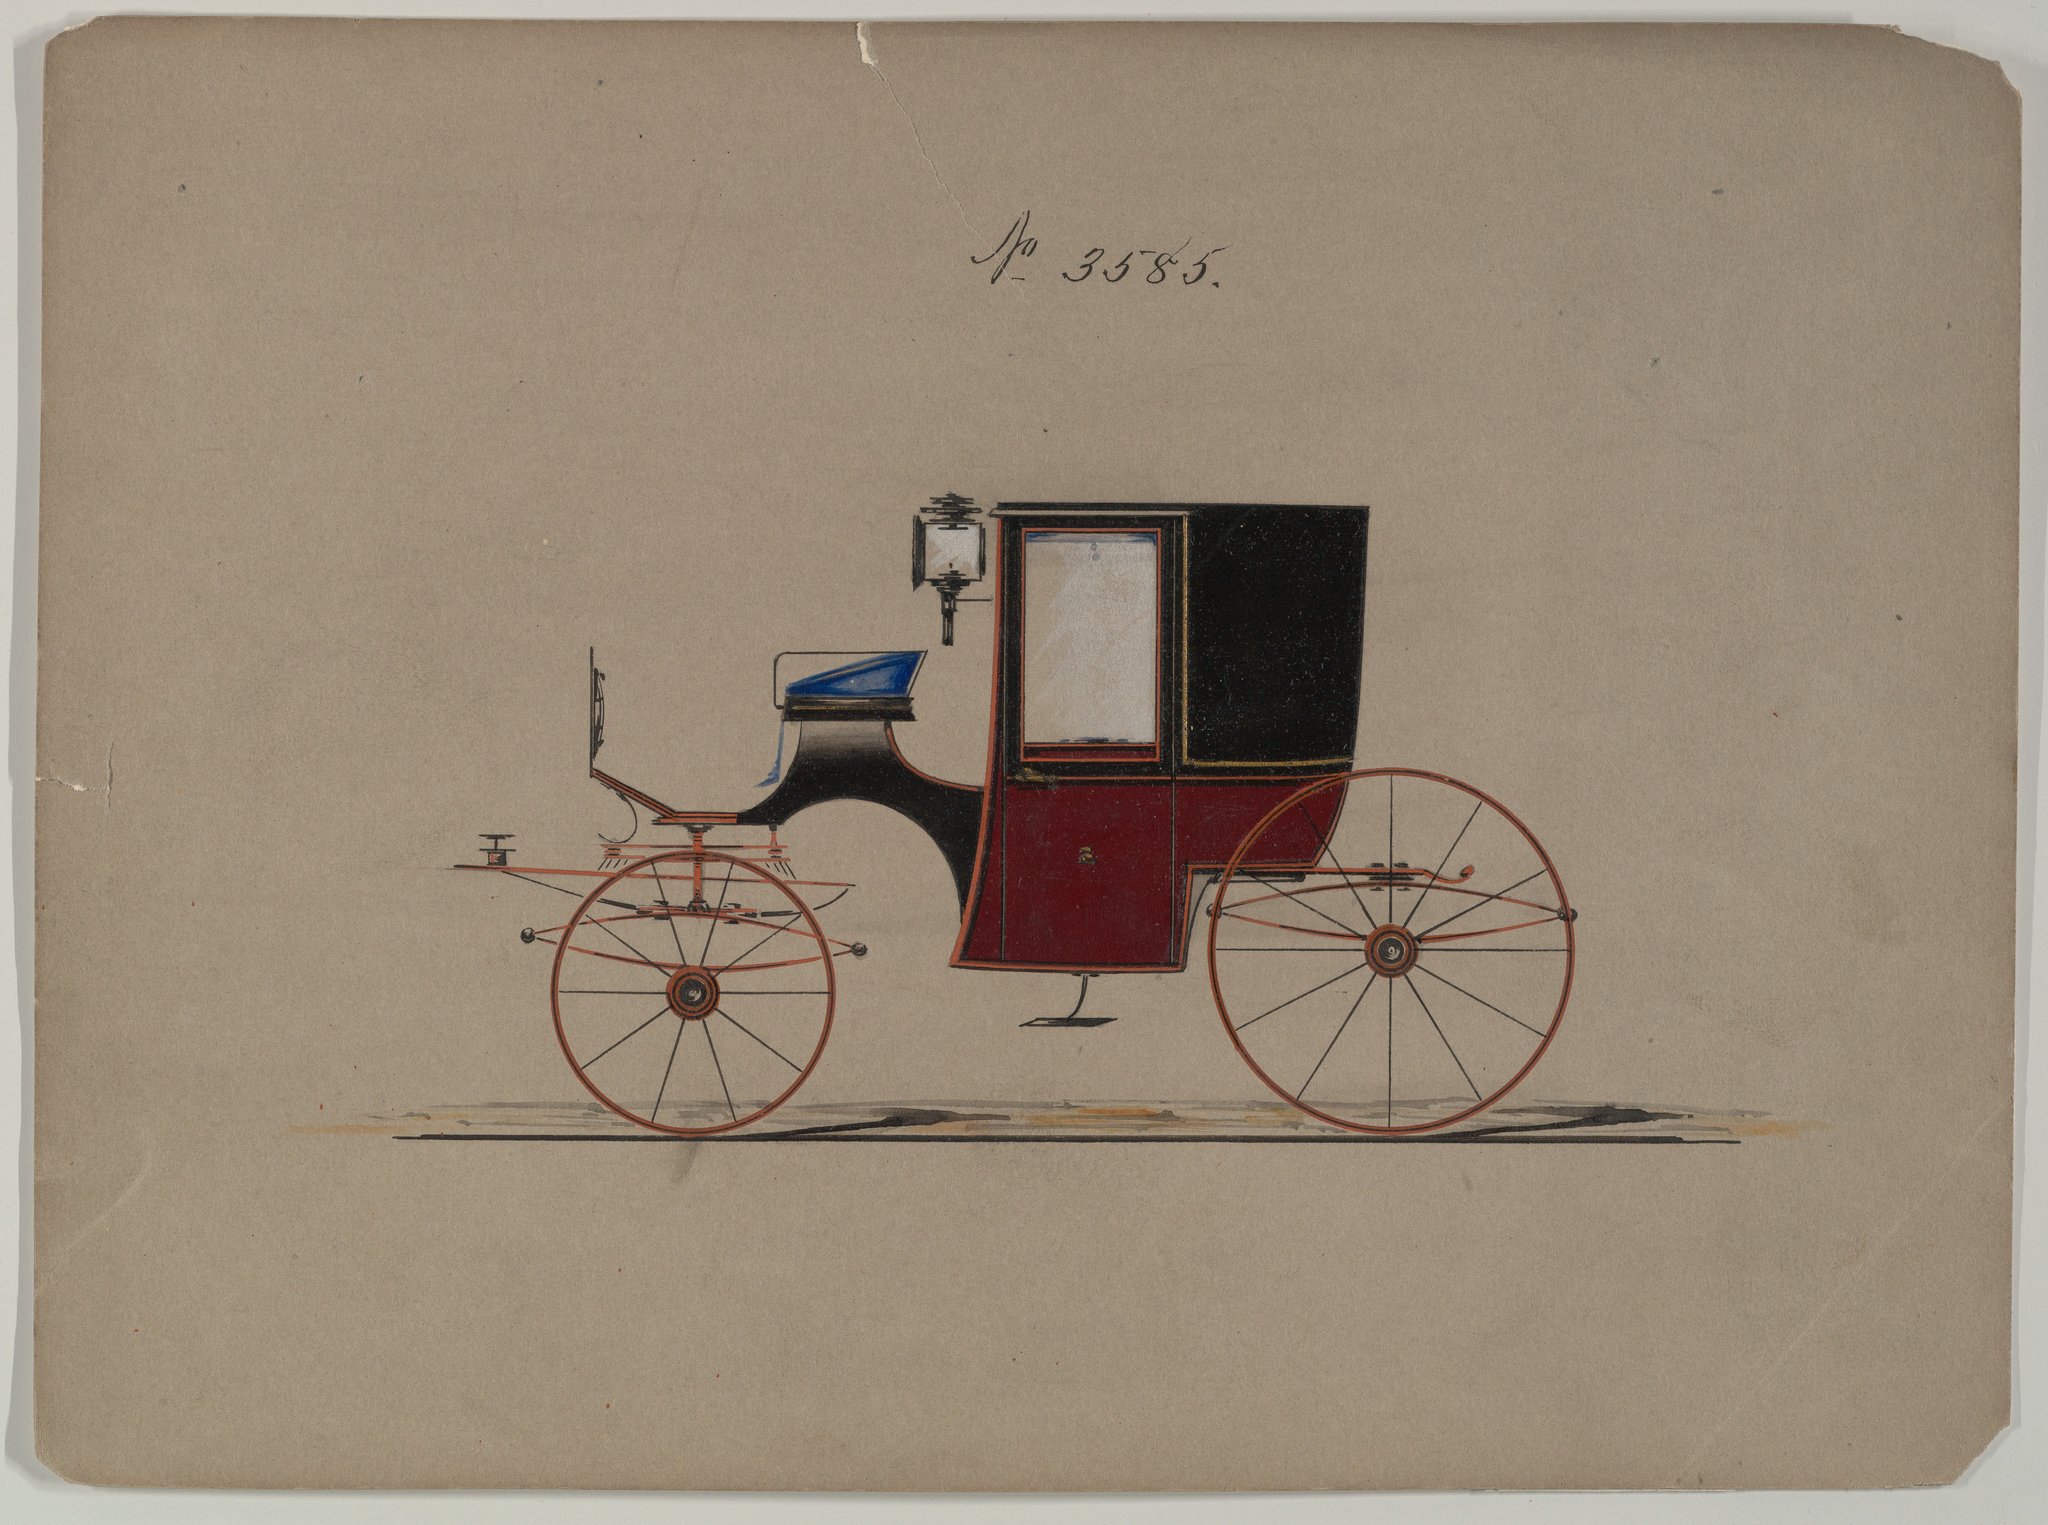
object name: drawing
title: Brougham #3585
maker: brewster & co.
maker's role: manufacturer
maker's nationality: american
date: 1880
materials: gouache, gum arabic, ink, watercolor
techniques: pen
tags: carriages